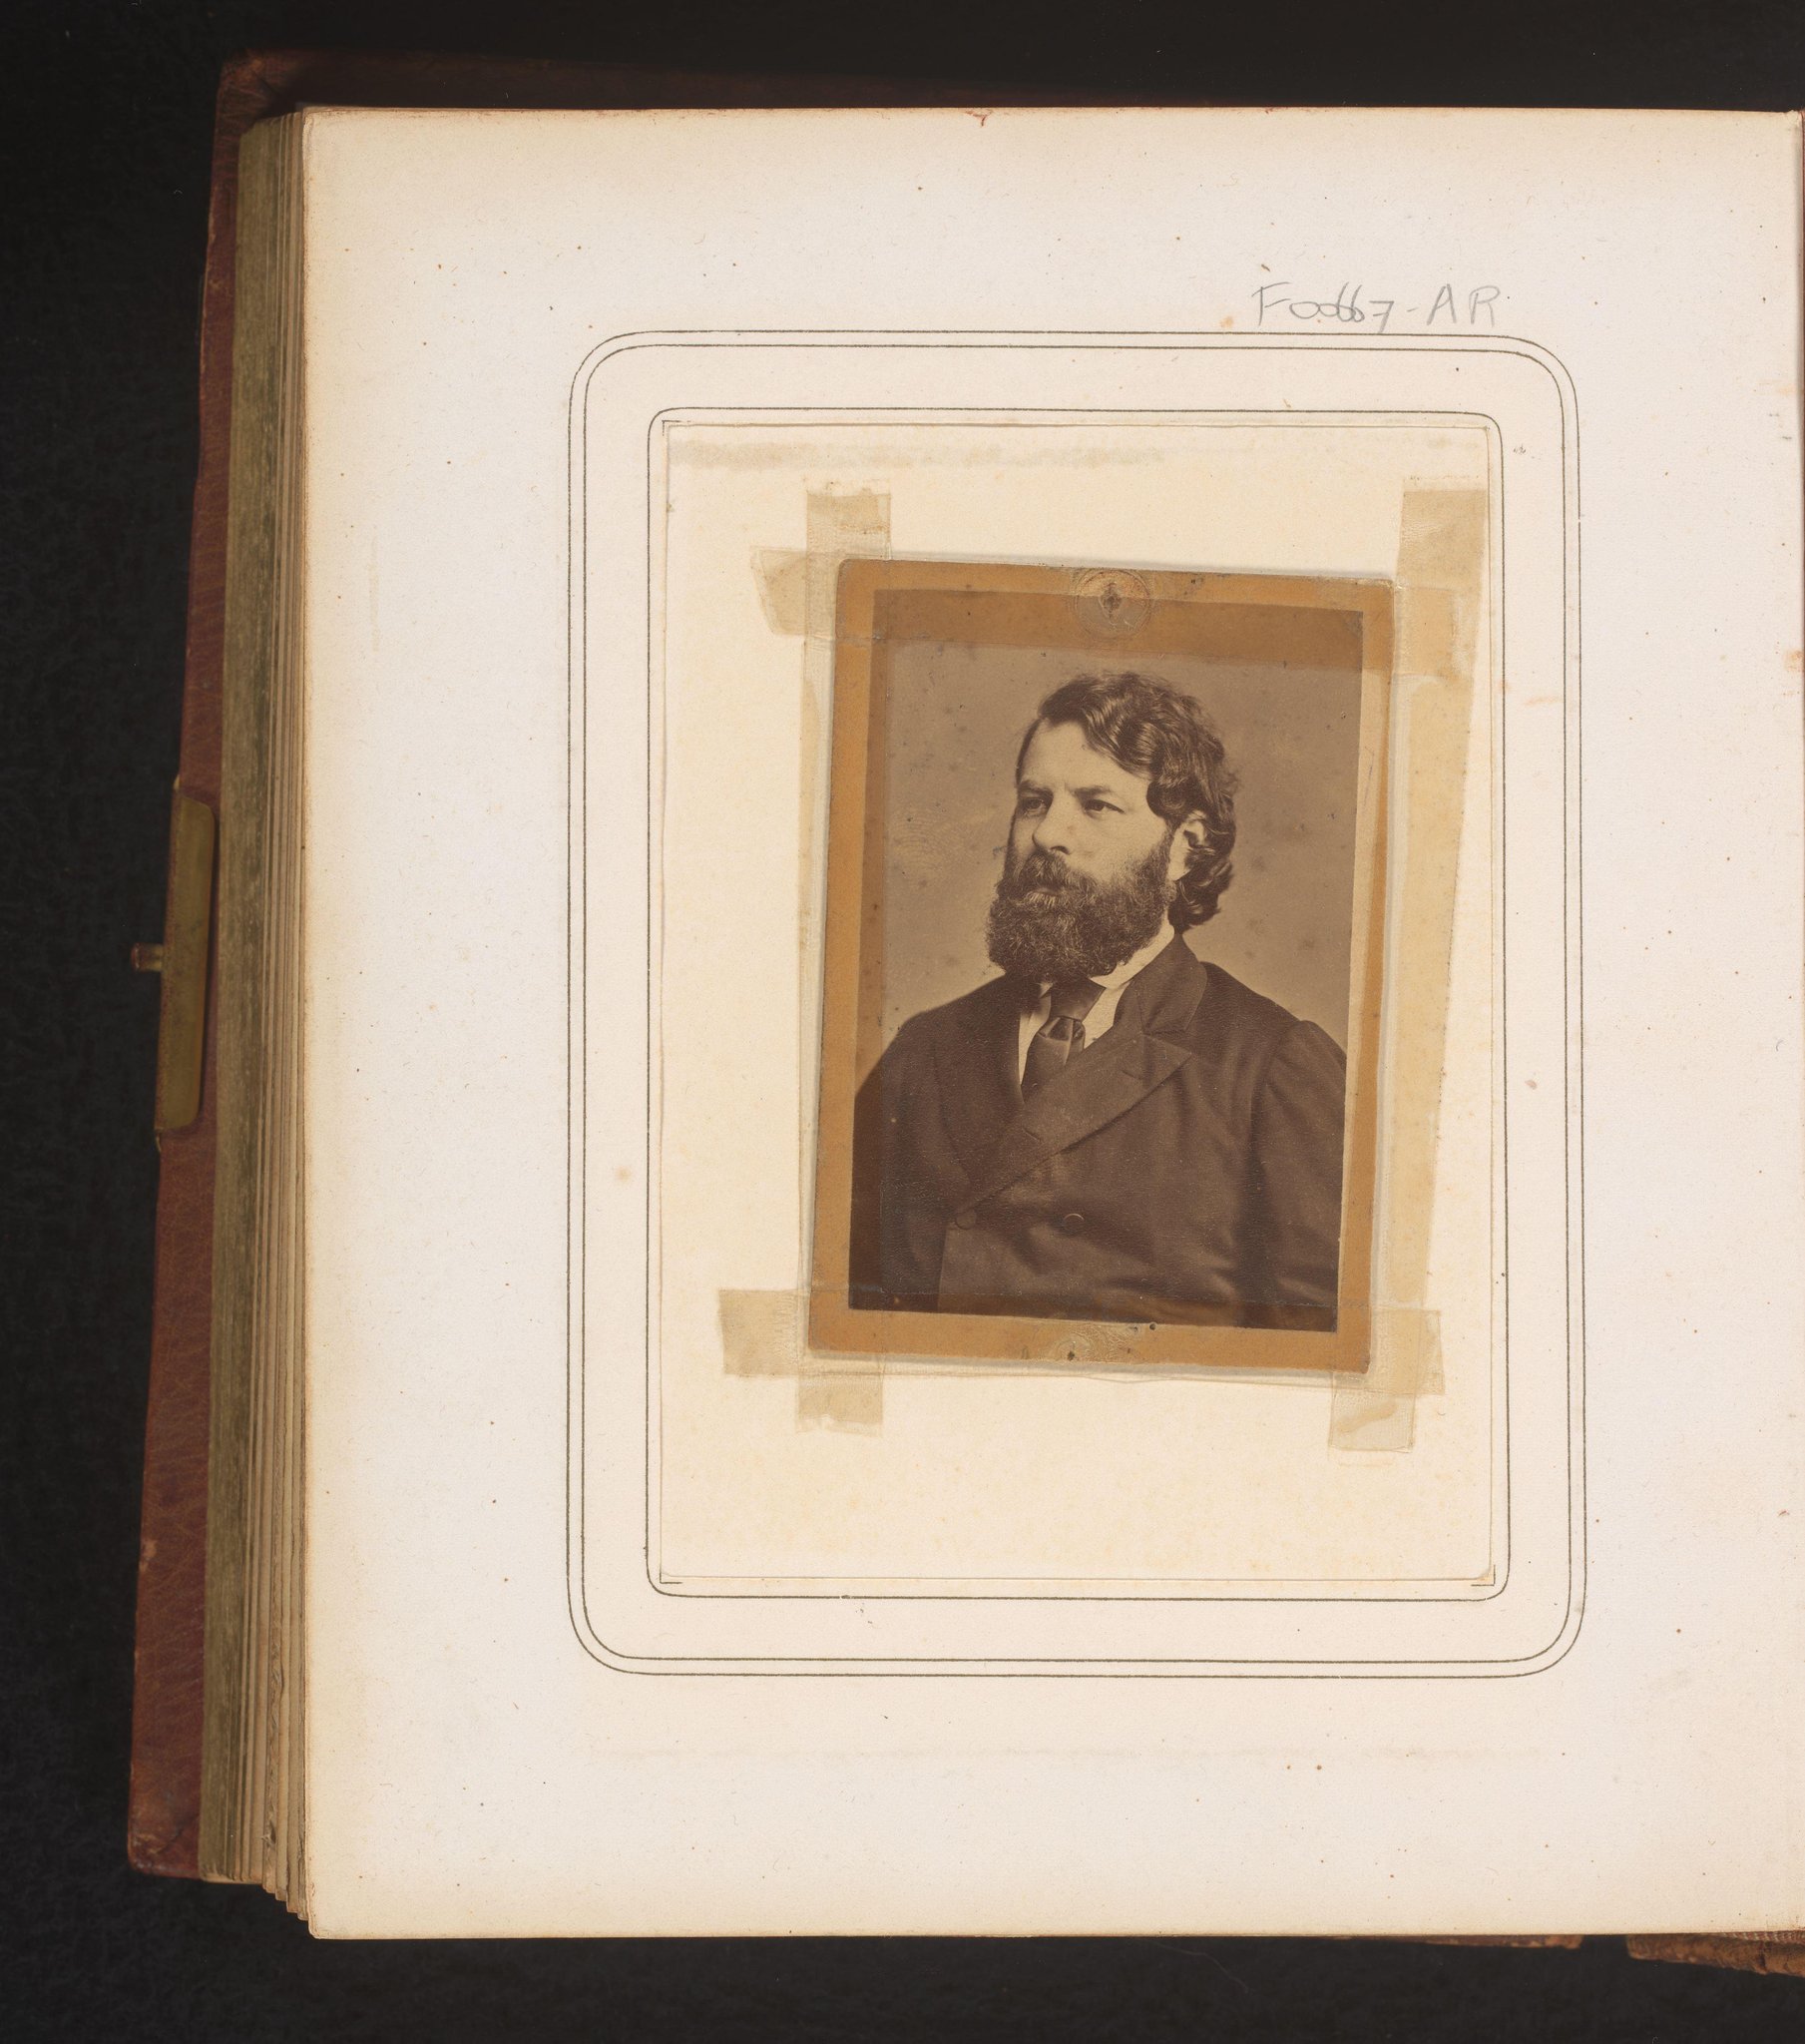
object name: carte de visite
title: Portret van Joseph Joachim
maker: Anonymous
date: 1871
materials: cardboard, photographic support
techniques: albumen print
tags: musician, adult man, historical persons, portrait of composer